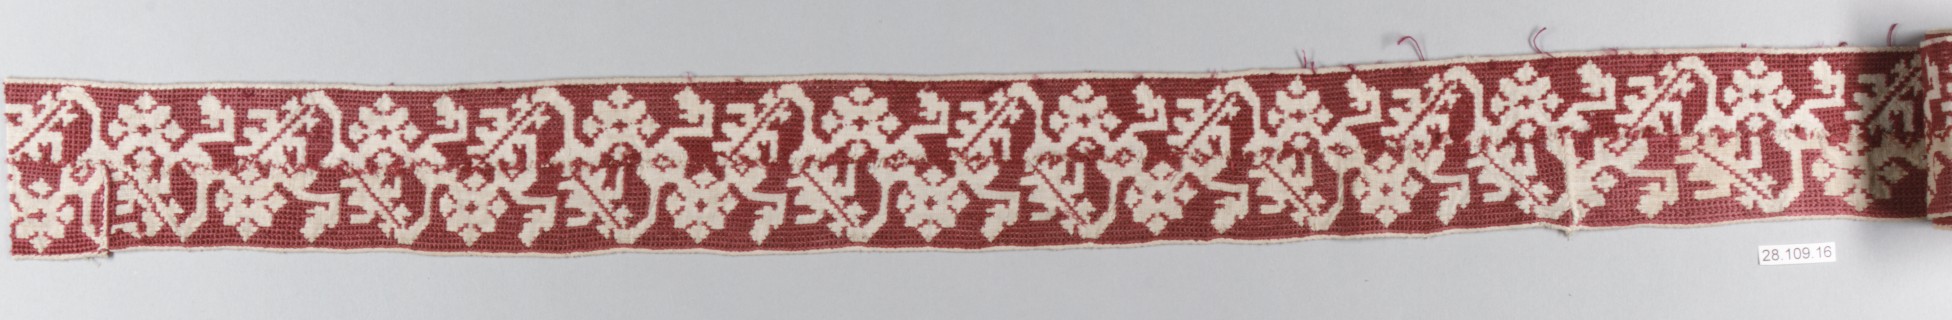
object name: fragment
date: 1601-1700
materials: cotton, silk